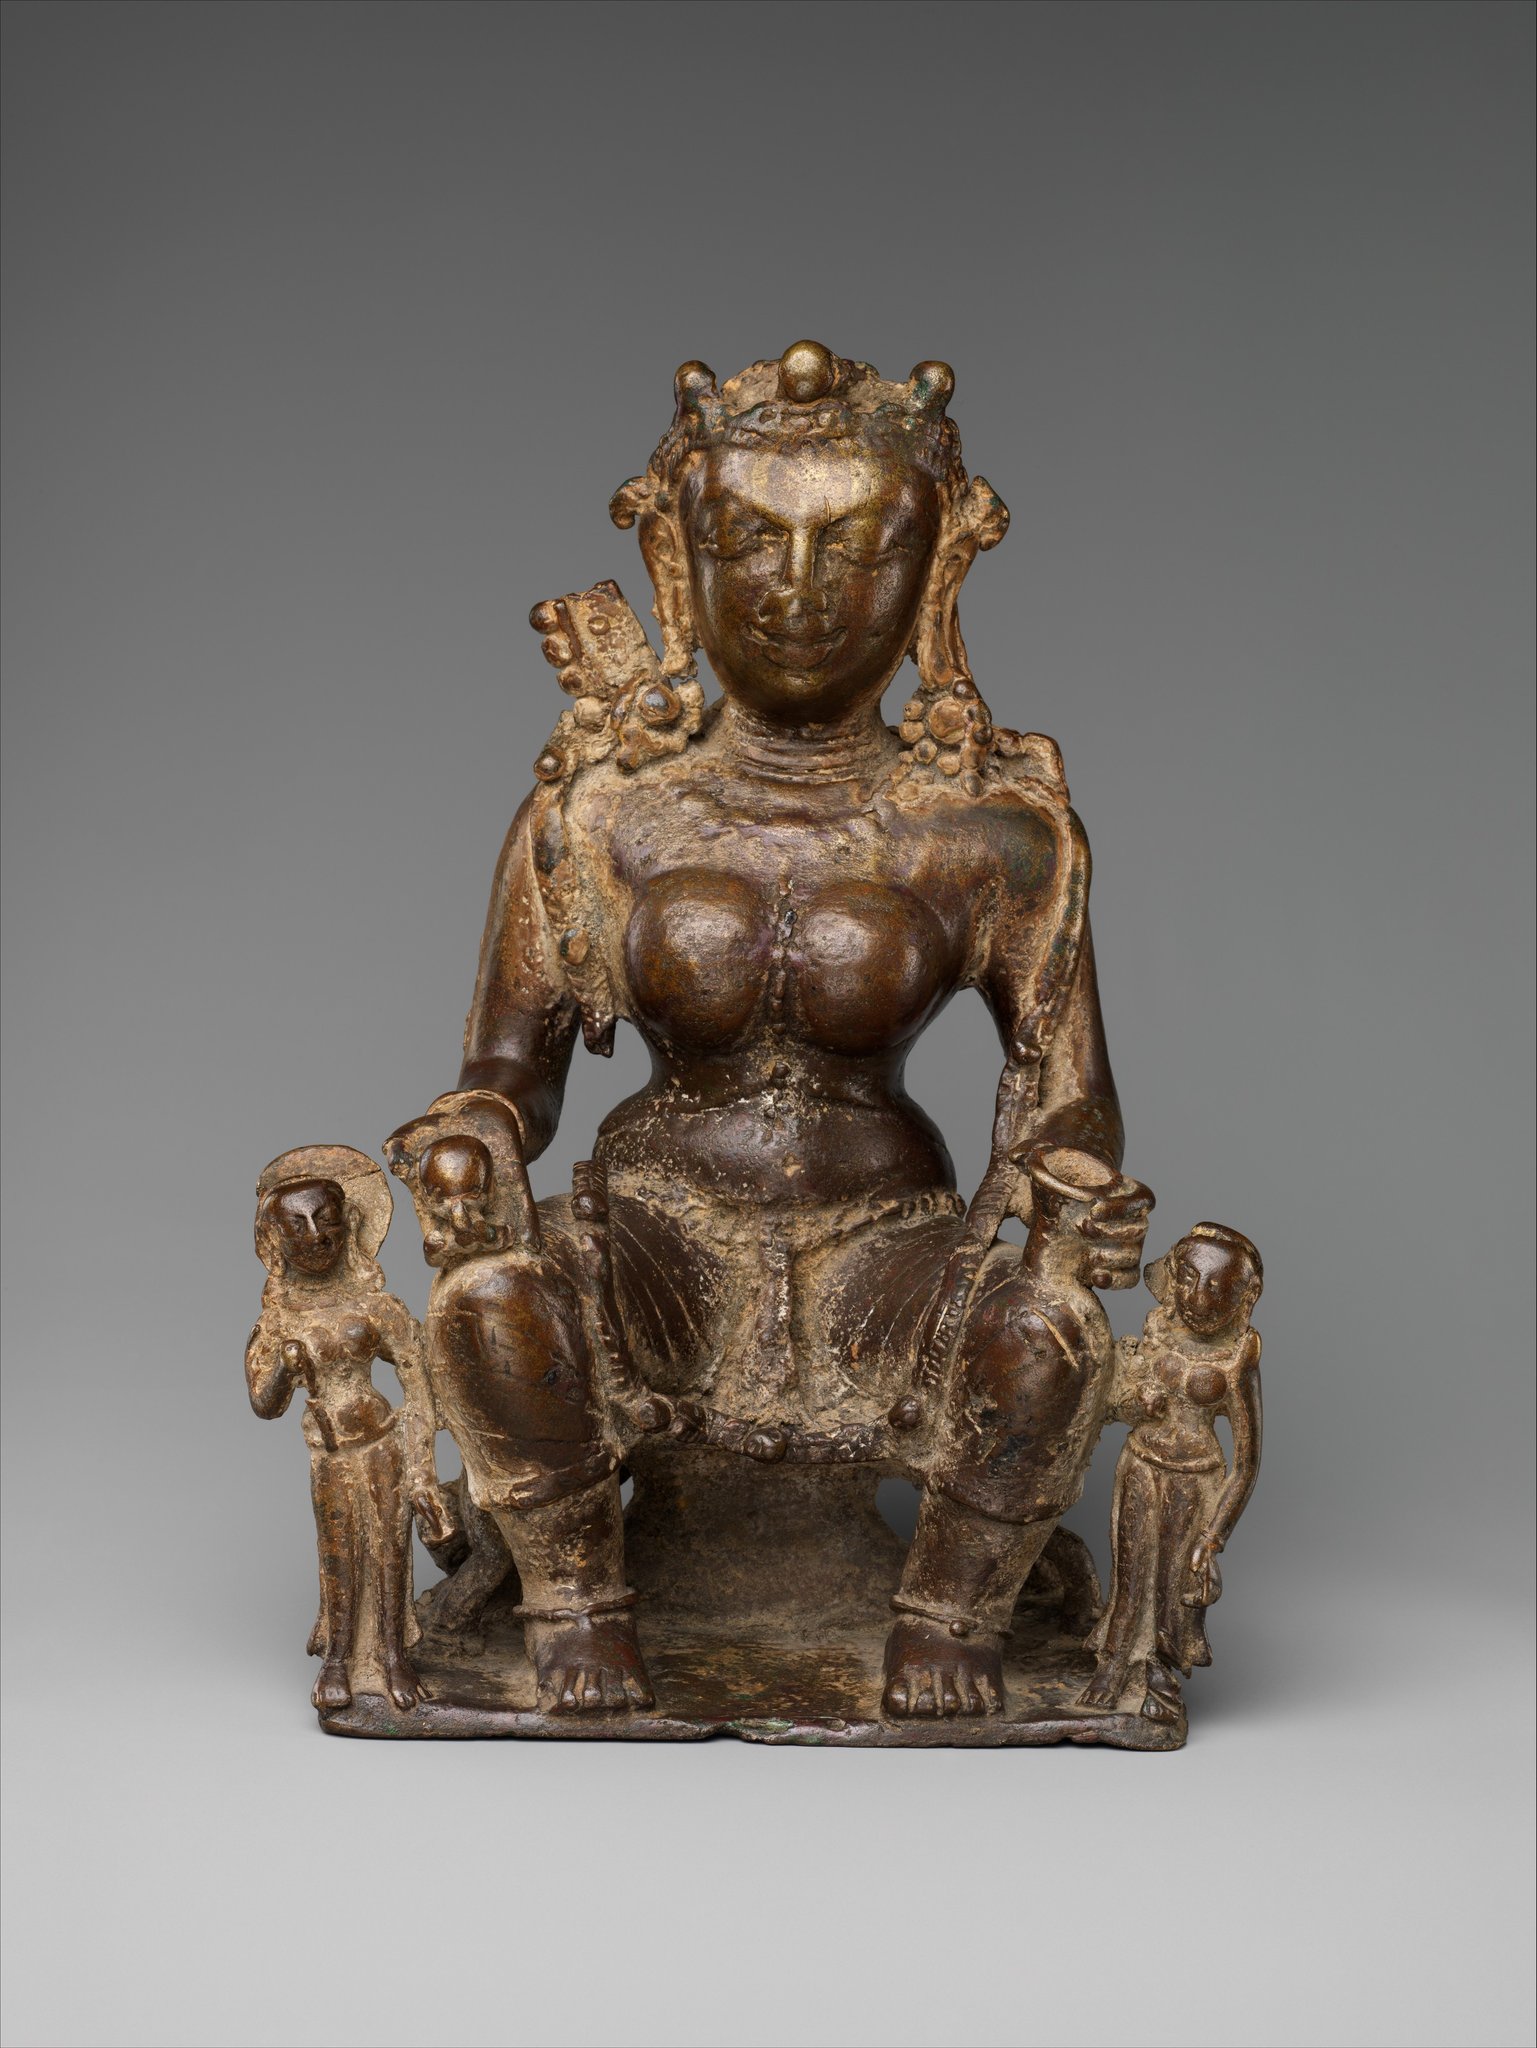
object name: figure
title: Lakshmi, Goddess of Prosperity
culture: india, himachal pradesh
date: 601-700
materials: brass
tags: goddess,hinduism